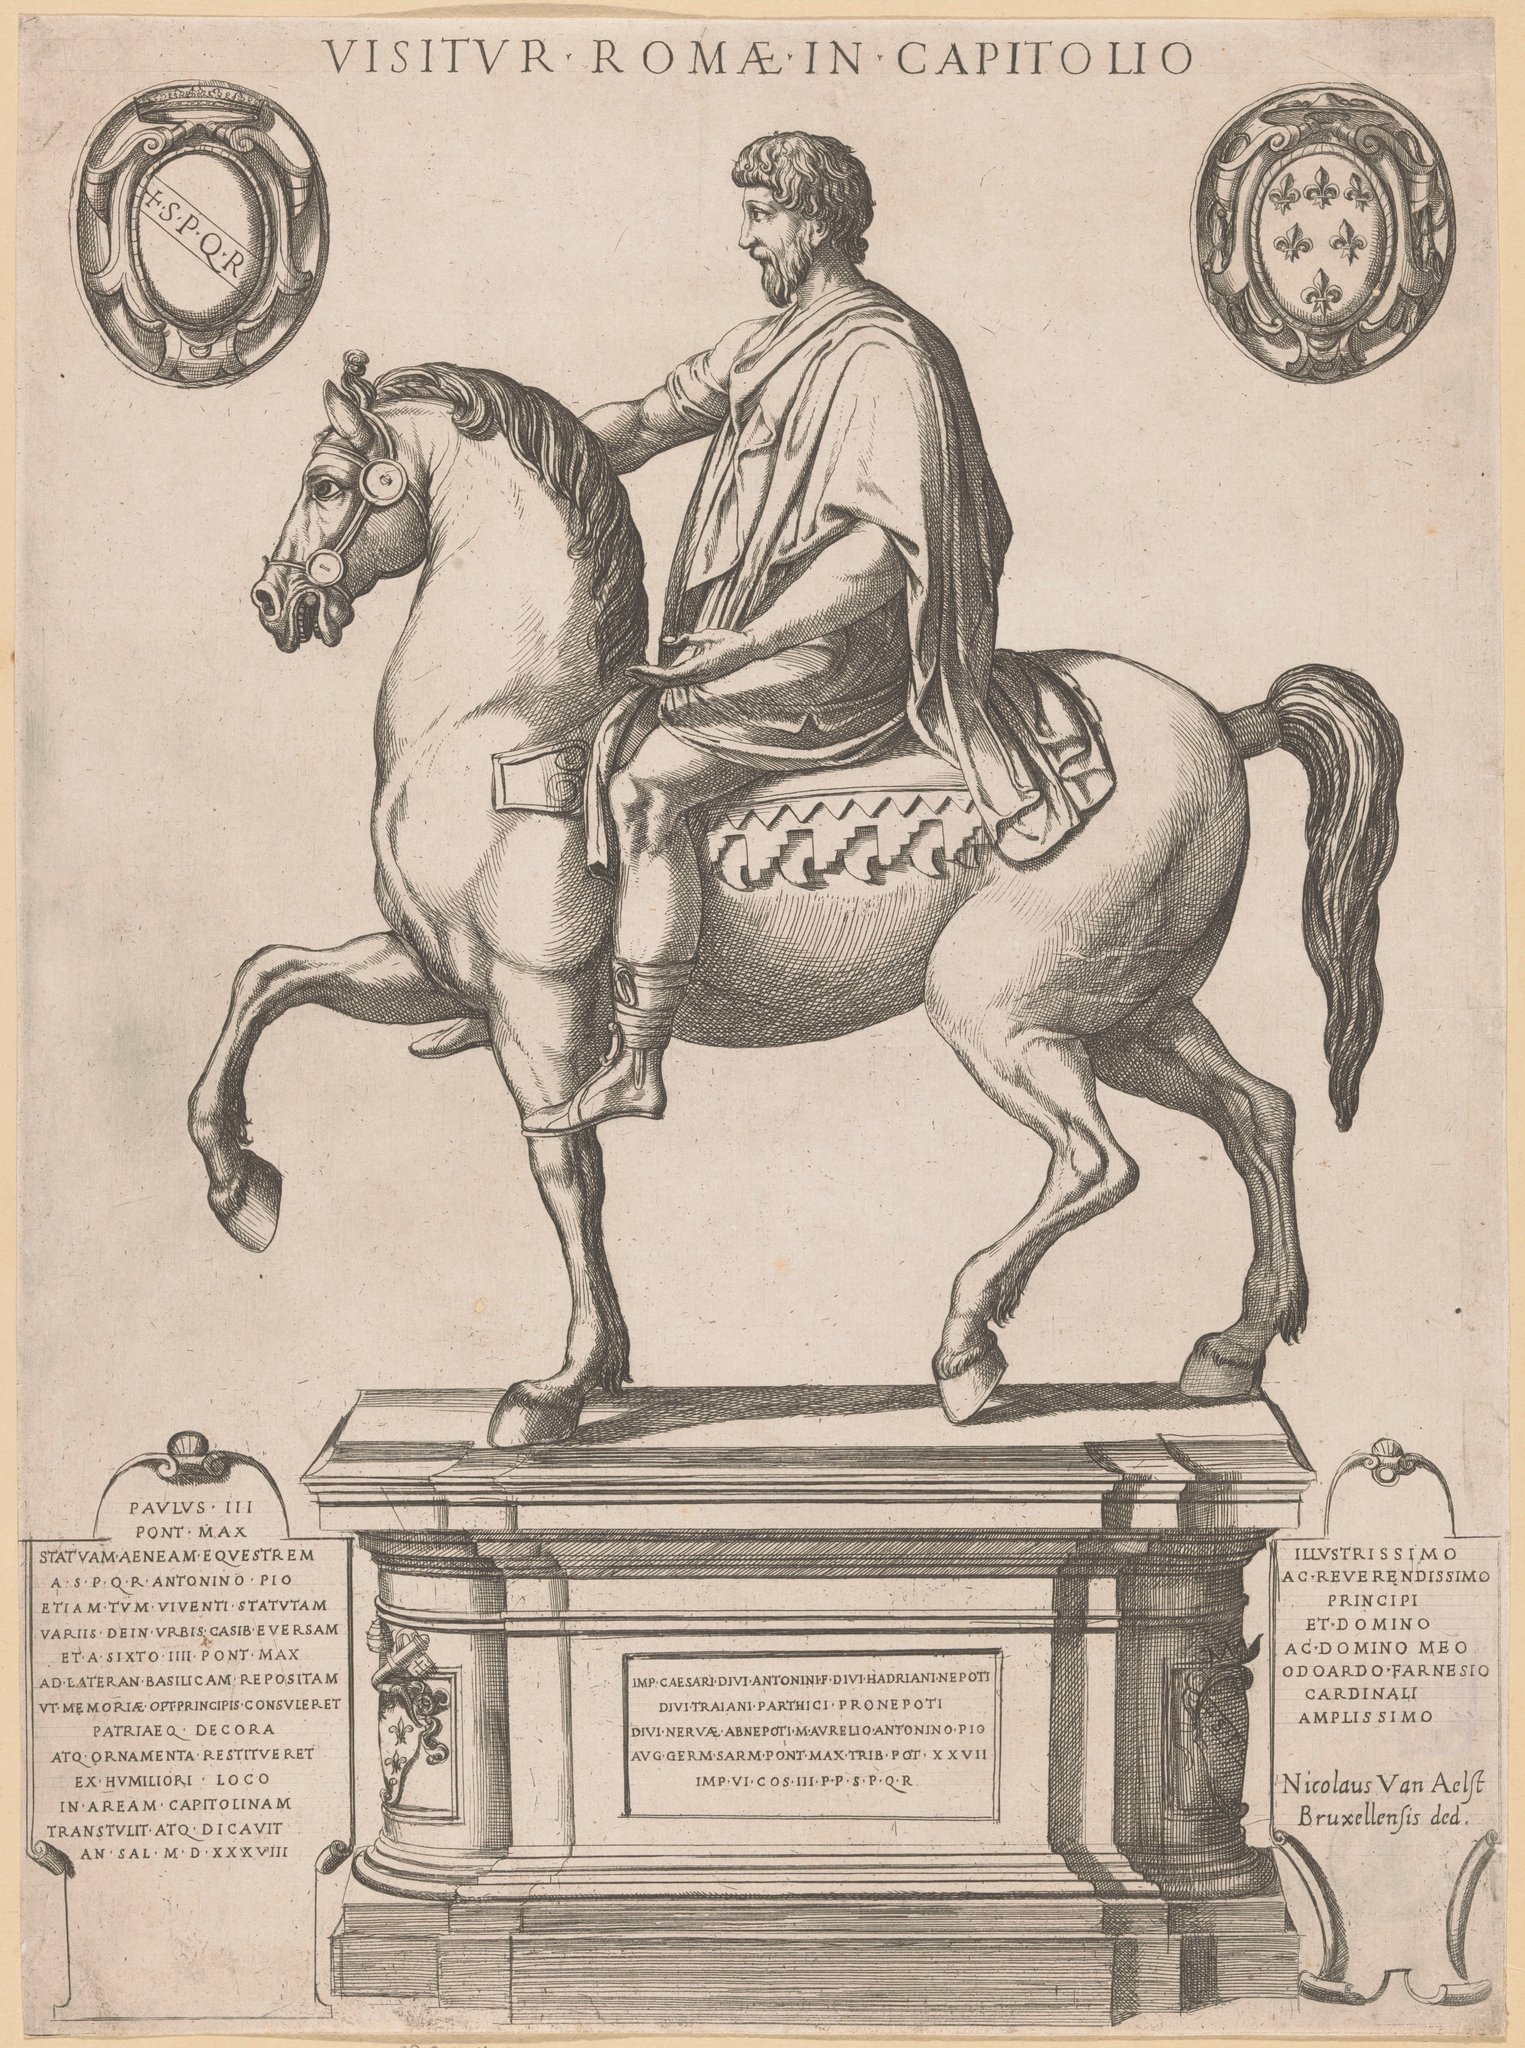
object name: print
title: Ruiterstandbeeld van Marcus Aurelius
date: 1591-1630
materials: paper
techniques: etching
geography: italy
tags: rome, equestrian statue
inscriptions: collector's mark: Lugt 11, collector's mark: Lugt 10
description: Het ruiterstandbeeld van Marcus Aurelius op Piazza del Campidoglio in Rome.